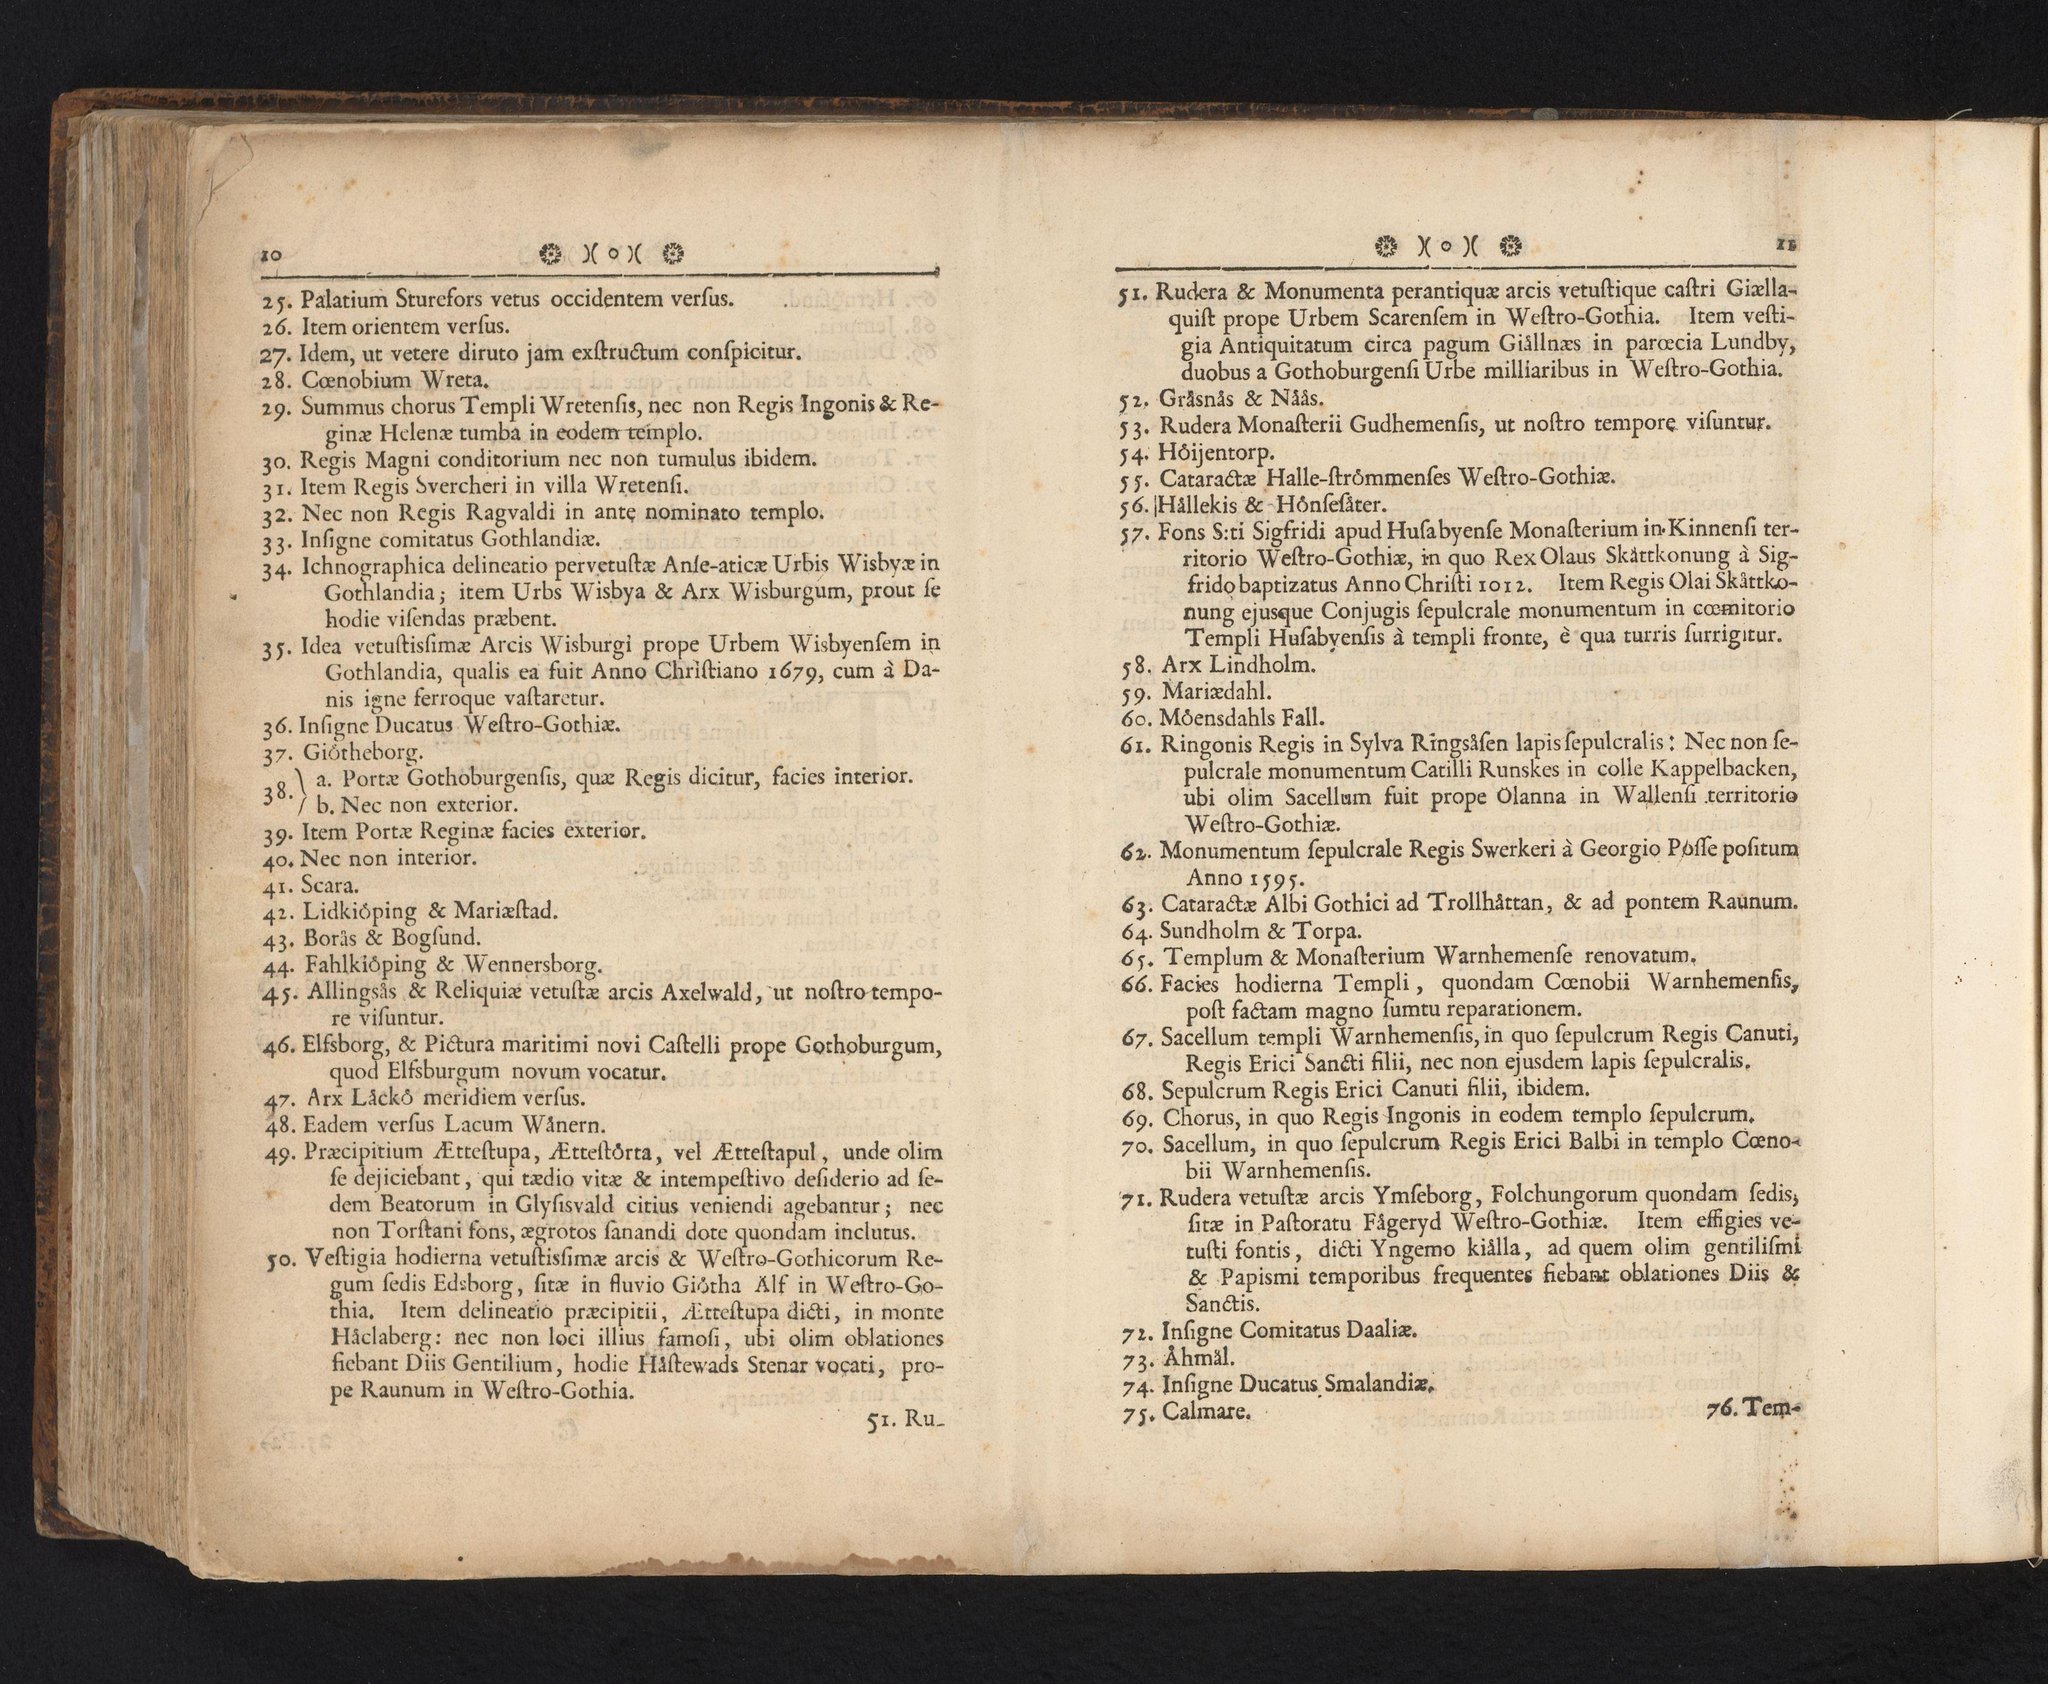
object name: text sheet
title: Index Figurarum Aenearum ad Sveciam Antiquam & Modernam pertinentium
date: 1661-1715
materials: paper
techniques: letterpress printing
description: Kungliga Biblioteket, 'Suecia': http://www.kb.se/samlingarna/Kartor-bilder/Suecia-antiqua/ (geraadpleegd november 2016).